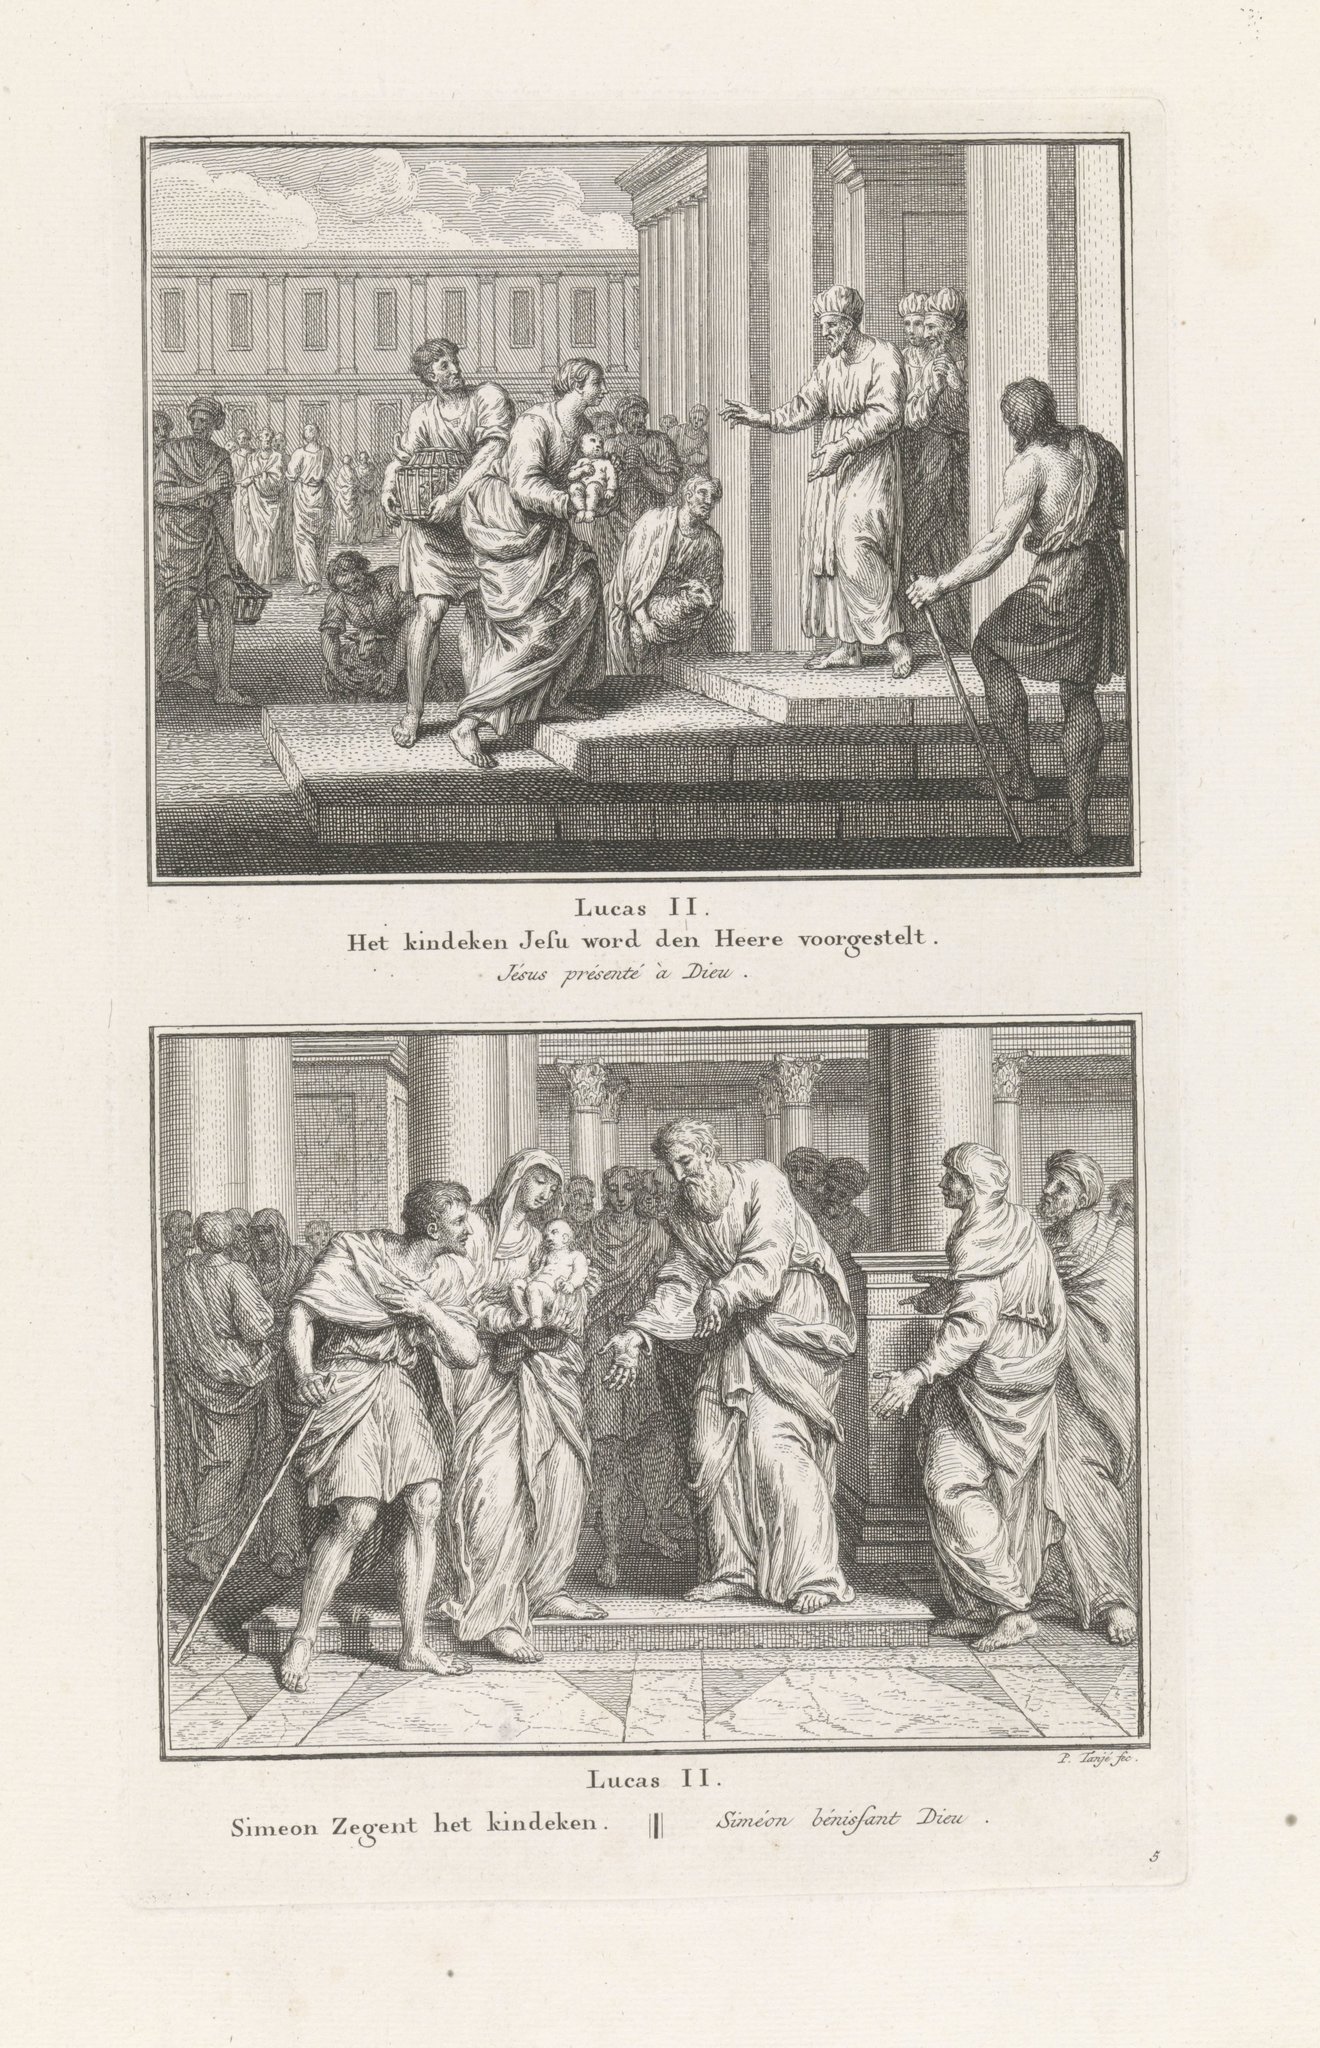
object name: book illustration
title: Het kindeken Jesu word den Heere voorgestelt (...) / Simeon Zegent het kindeken (...)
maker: pieter tanjé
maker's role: draughtsman, print maker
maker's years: 1706-1761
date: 1716-1761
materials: paper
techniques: engraving, etching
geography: amsterdam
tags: mary and joseph blessed by simeon ~ presentation of the christ-child, presentation of the christ-child in the temple, usually simeon (and anna) present (luke 2:22-39)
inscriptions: collector's mark: Lugt 2233, collector's mark: Lugt 3937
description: Prent mogelijk gebruikt in: Hamelsveld, Ysbrand van. De gewigtigste geschiedenissen des Bybels, afgebeeld in twee honderd twee en vĳftig printverbeeldingen (...) met eene zaaklĳke uitbreiding opgehelderd. Amsterdam: Jan de Groot, Gerrit Warnars, Petrus van Hengst, Dordrecht: Abraham Blussé, Pieter Blussé, Leiden: Samuel Luchtmans (III), Johannes Luchtmans, Harlingen: Volkert van der Plaats, 1791.